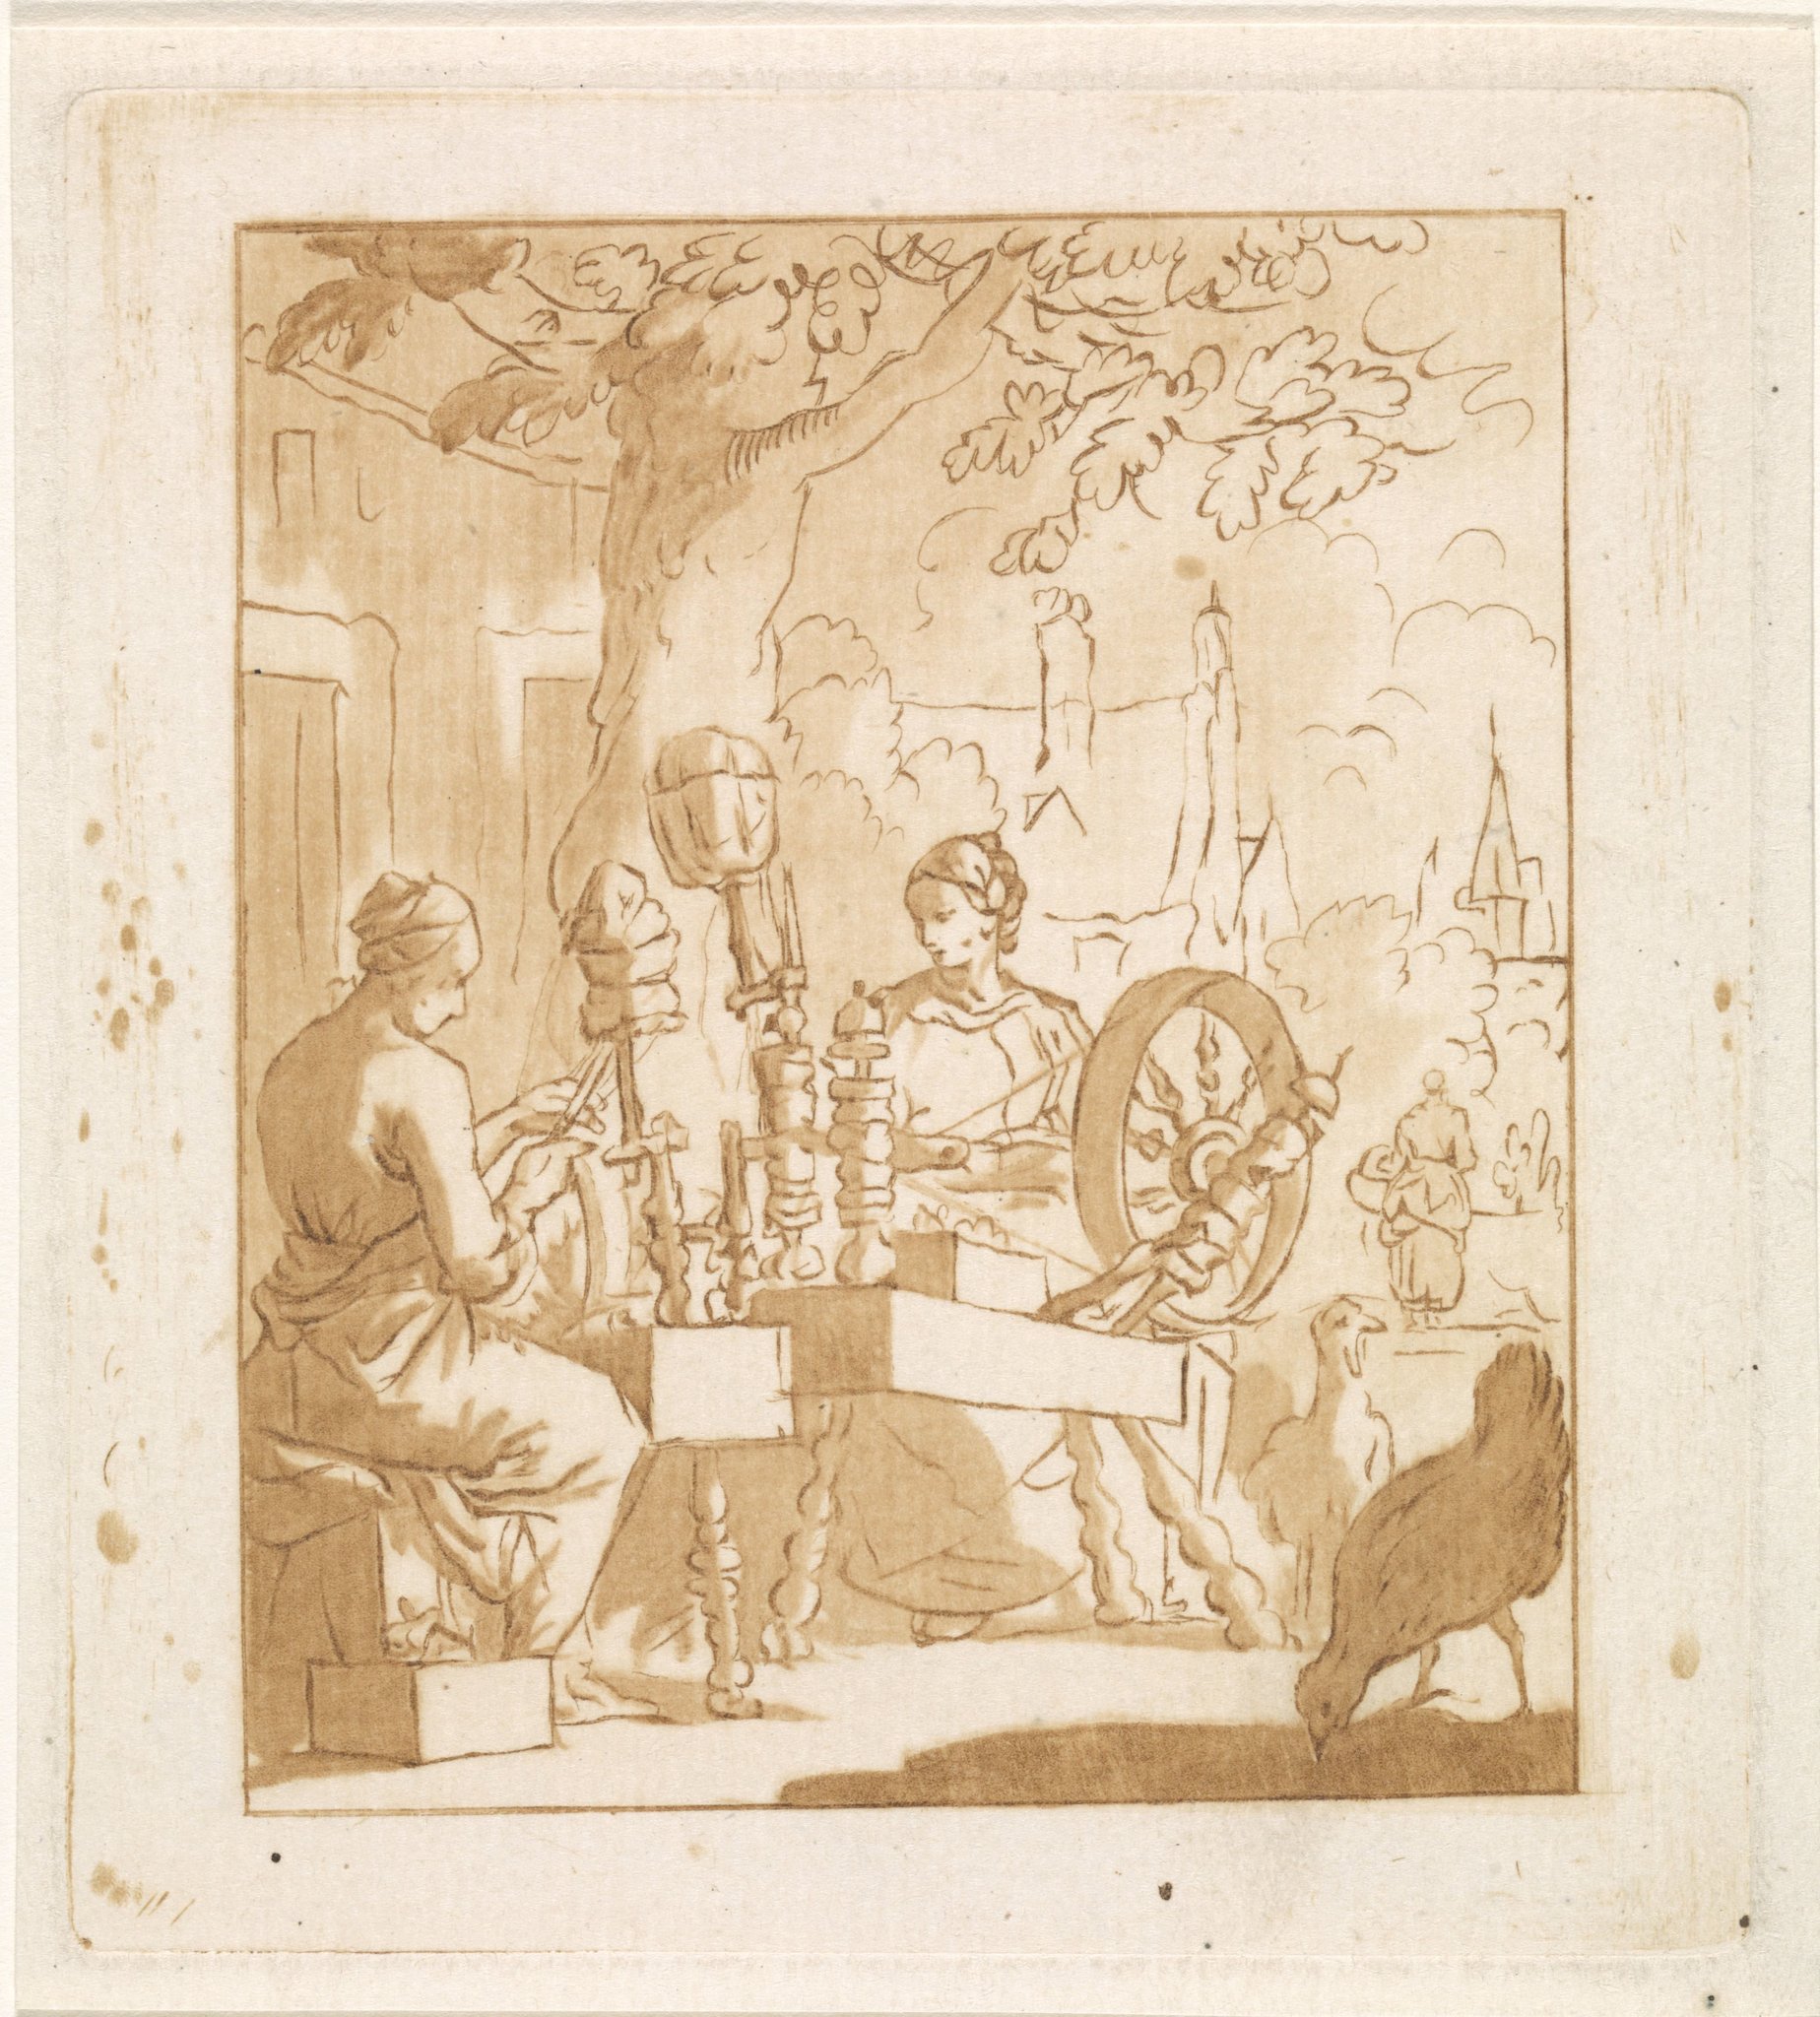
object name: print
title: Spinnende vrouwen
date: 1740-1780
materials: paper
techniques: print drawing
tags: spindle, fowl (cock, hen, chicken, etc.)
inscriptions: collector's mark: Lugt 2228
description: Onder een boom in een dorpstraat zitten twee vrouwen te spinnen. Op de voorgrond scharrelen twee kippen, en op de achtergrond zijn gebouwen te zien.